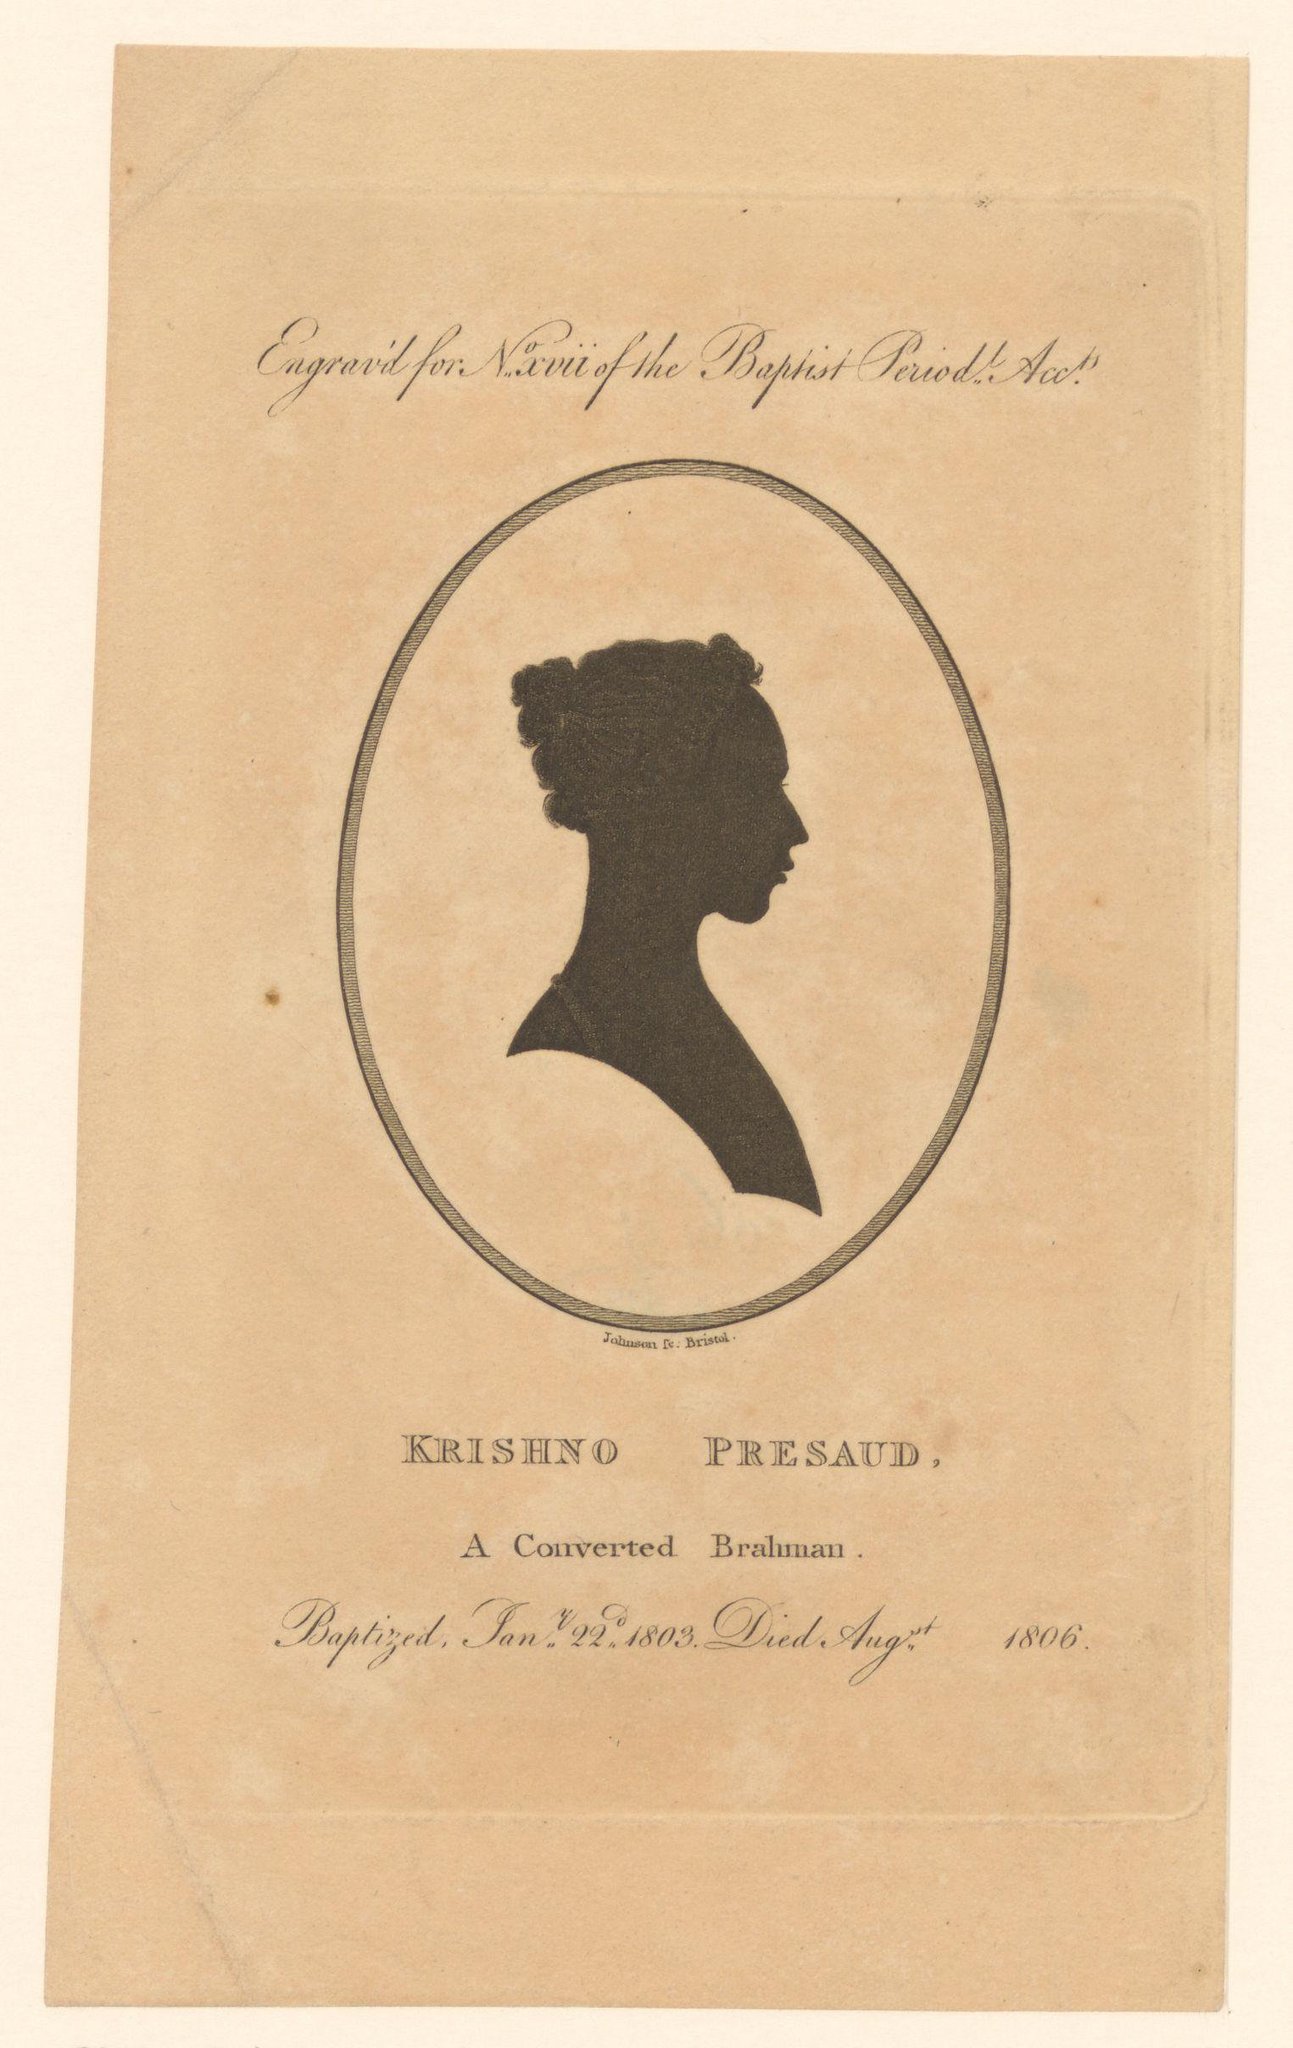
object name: print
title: Silhouetportret van Krishno Presaud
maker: g. johnson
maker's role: print maker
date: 1806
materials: paper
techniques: etching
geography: bristol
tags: historical persons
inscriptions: collector's mark: Lugt 2228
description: Prent gebruikt in: Periodical accounts relative to the Baptist Missionary Society 3 (1806).